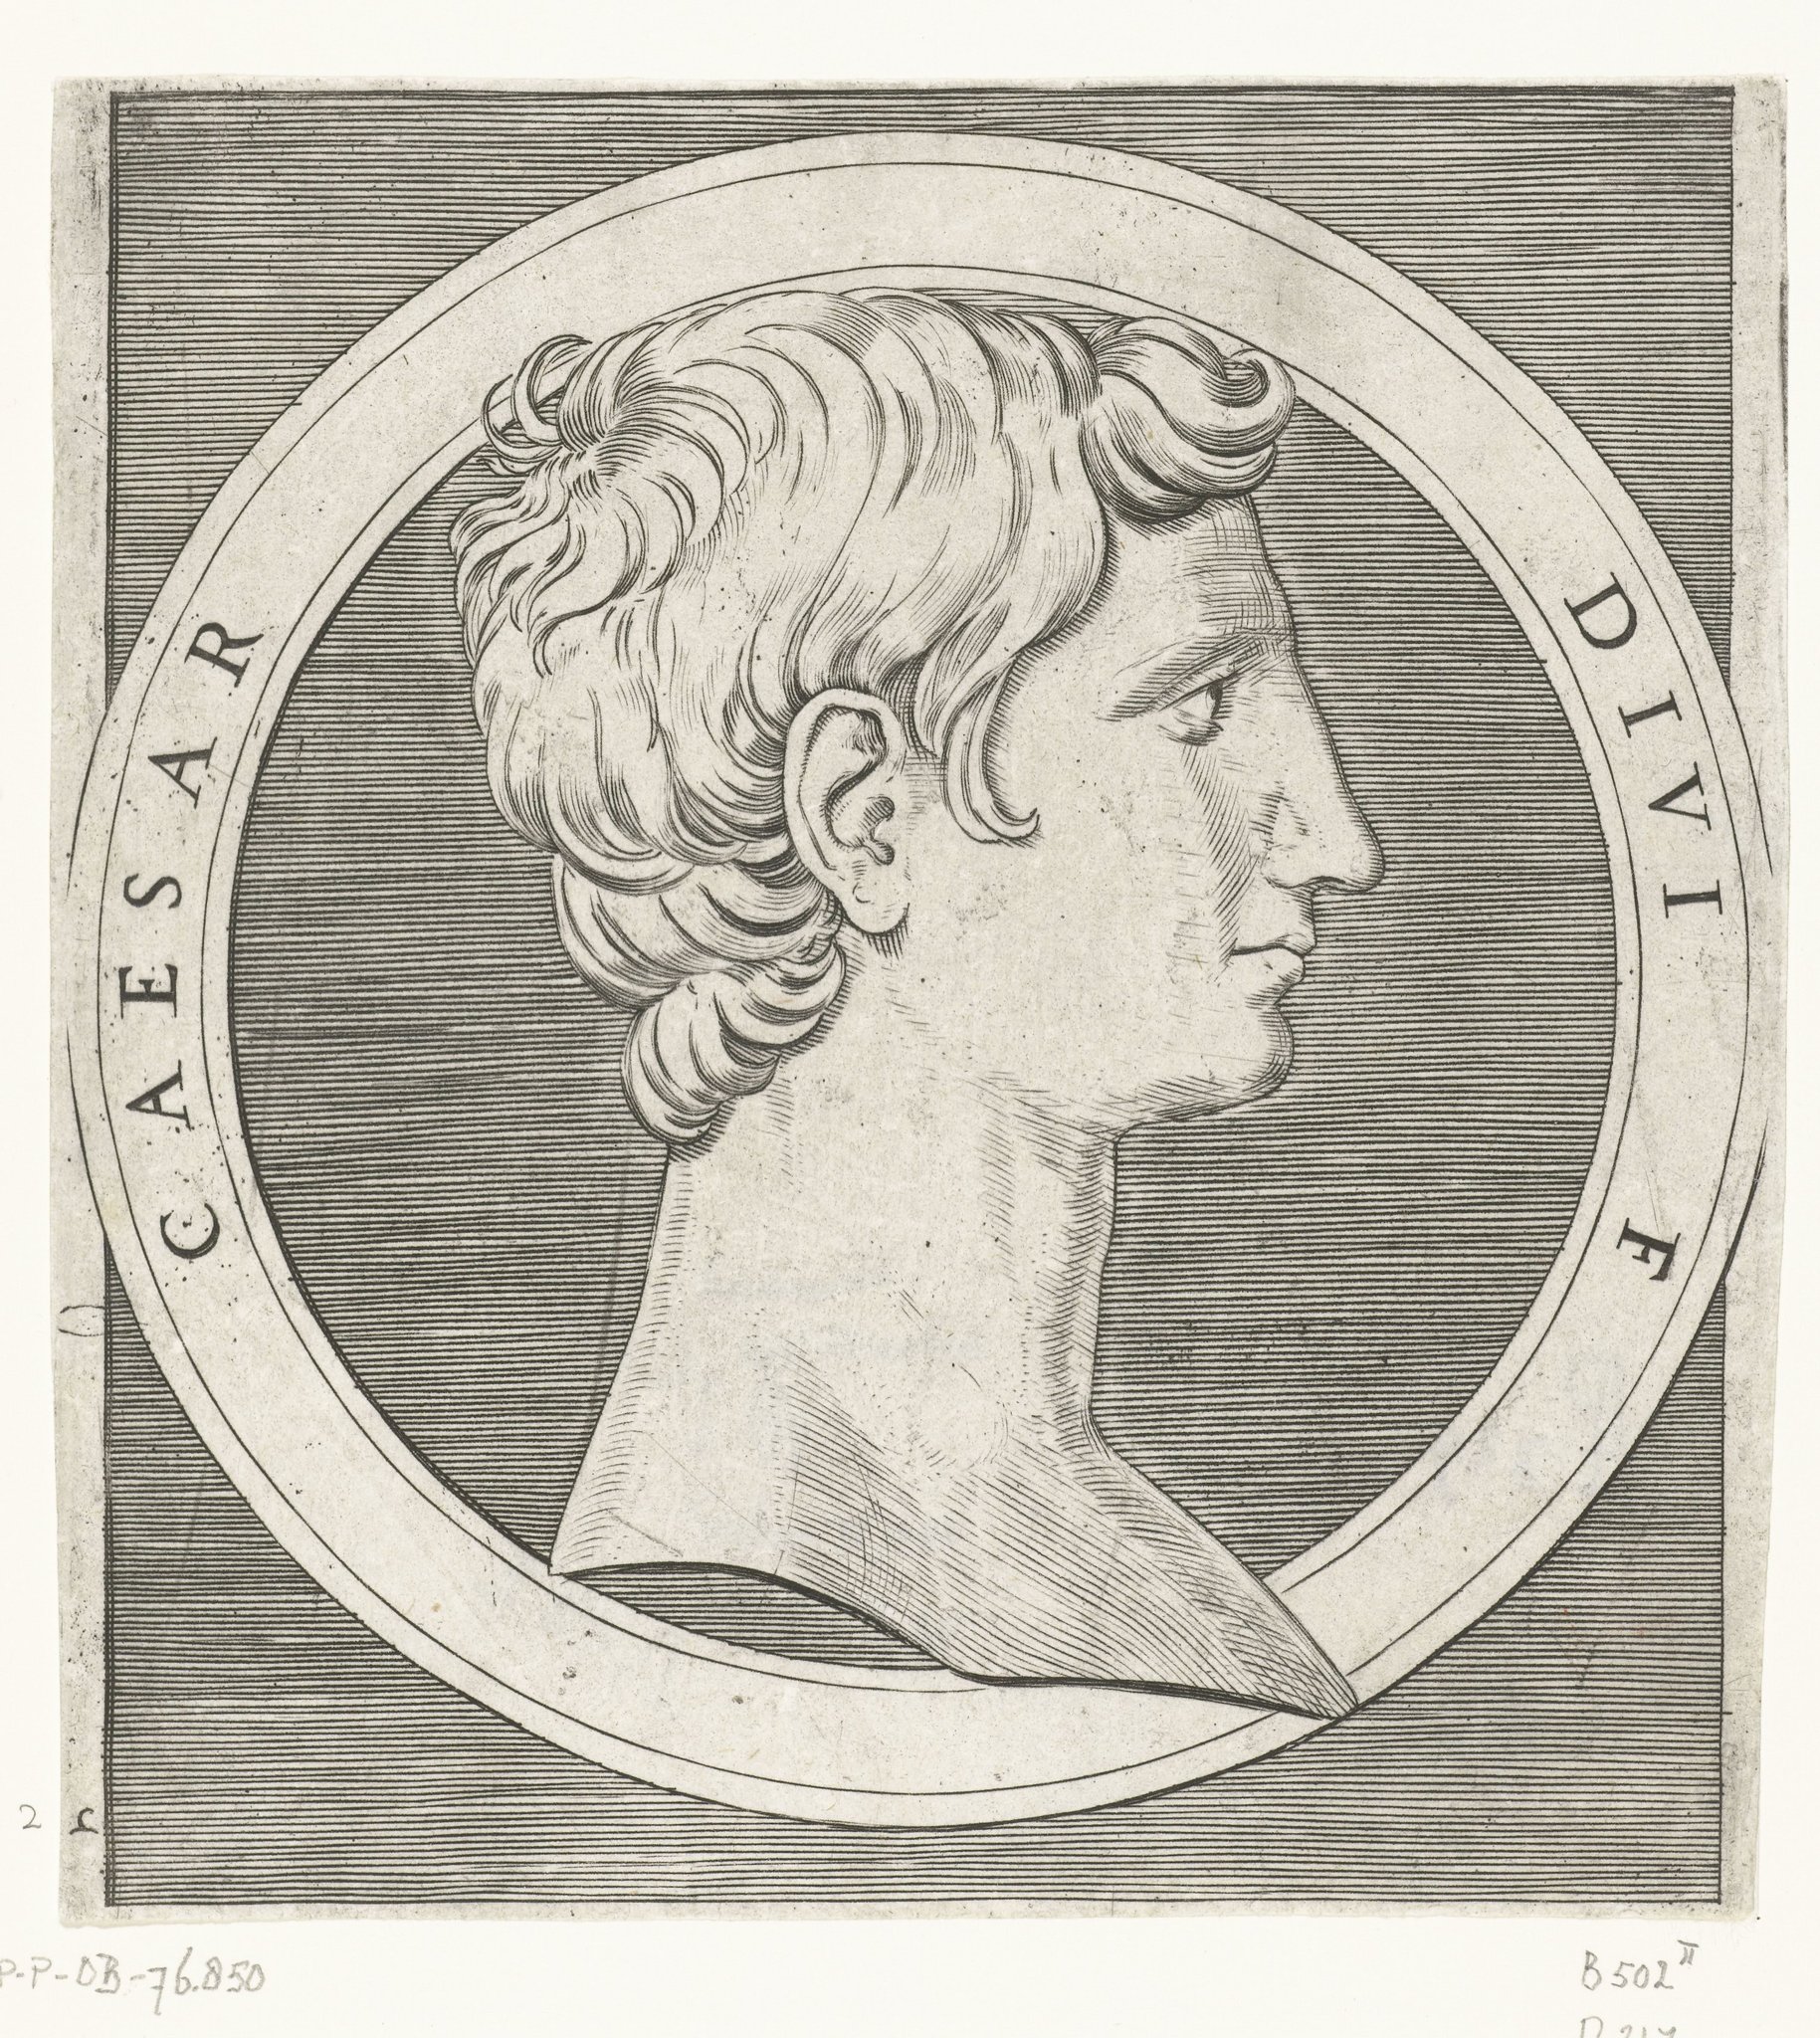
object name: print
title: Romeinse keizers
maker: marcantonio raimondi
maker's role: print maker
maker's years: 1470-1534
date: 1510-1527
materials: paper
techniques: engraving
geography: italy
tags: emperor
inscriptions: collector's mark: Lugt 12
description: Prent uit serie van twaalf prenten met Romeinse keizers.